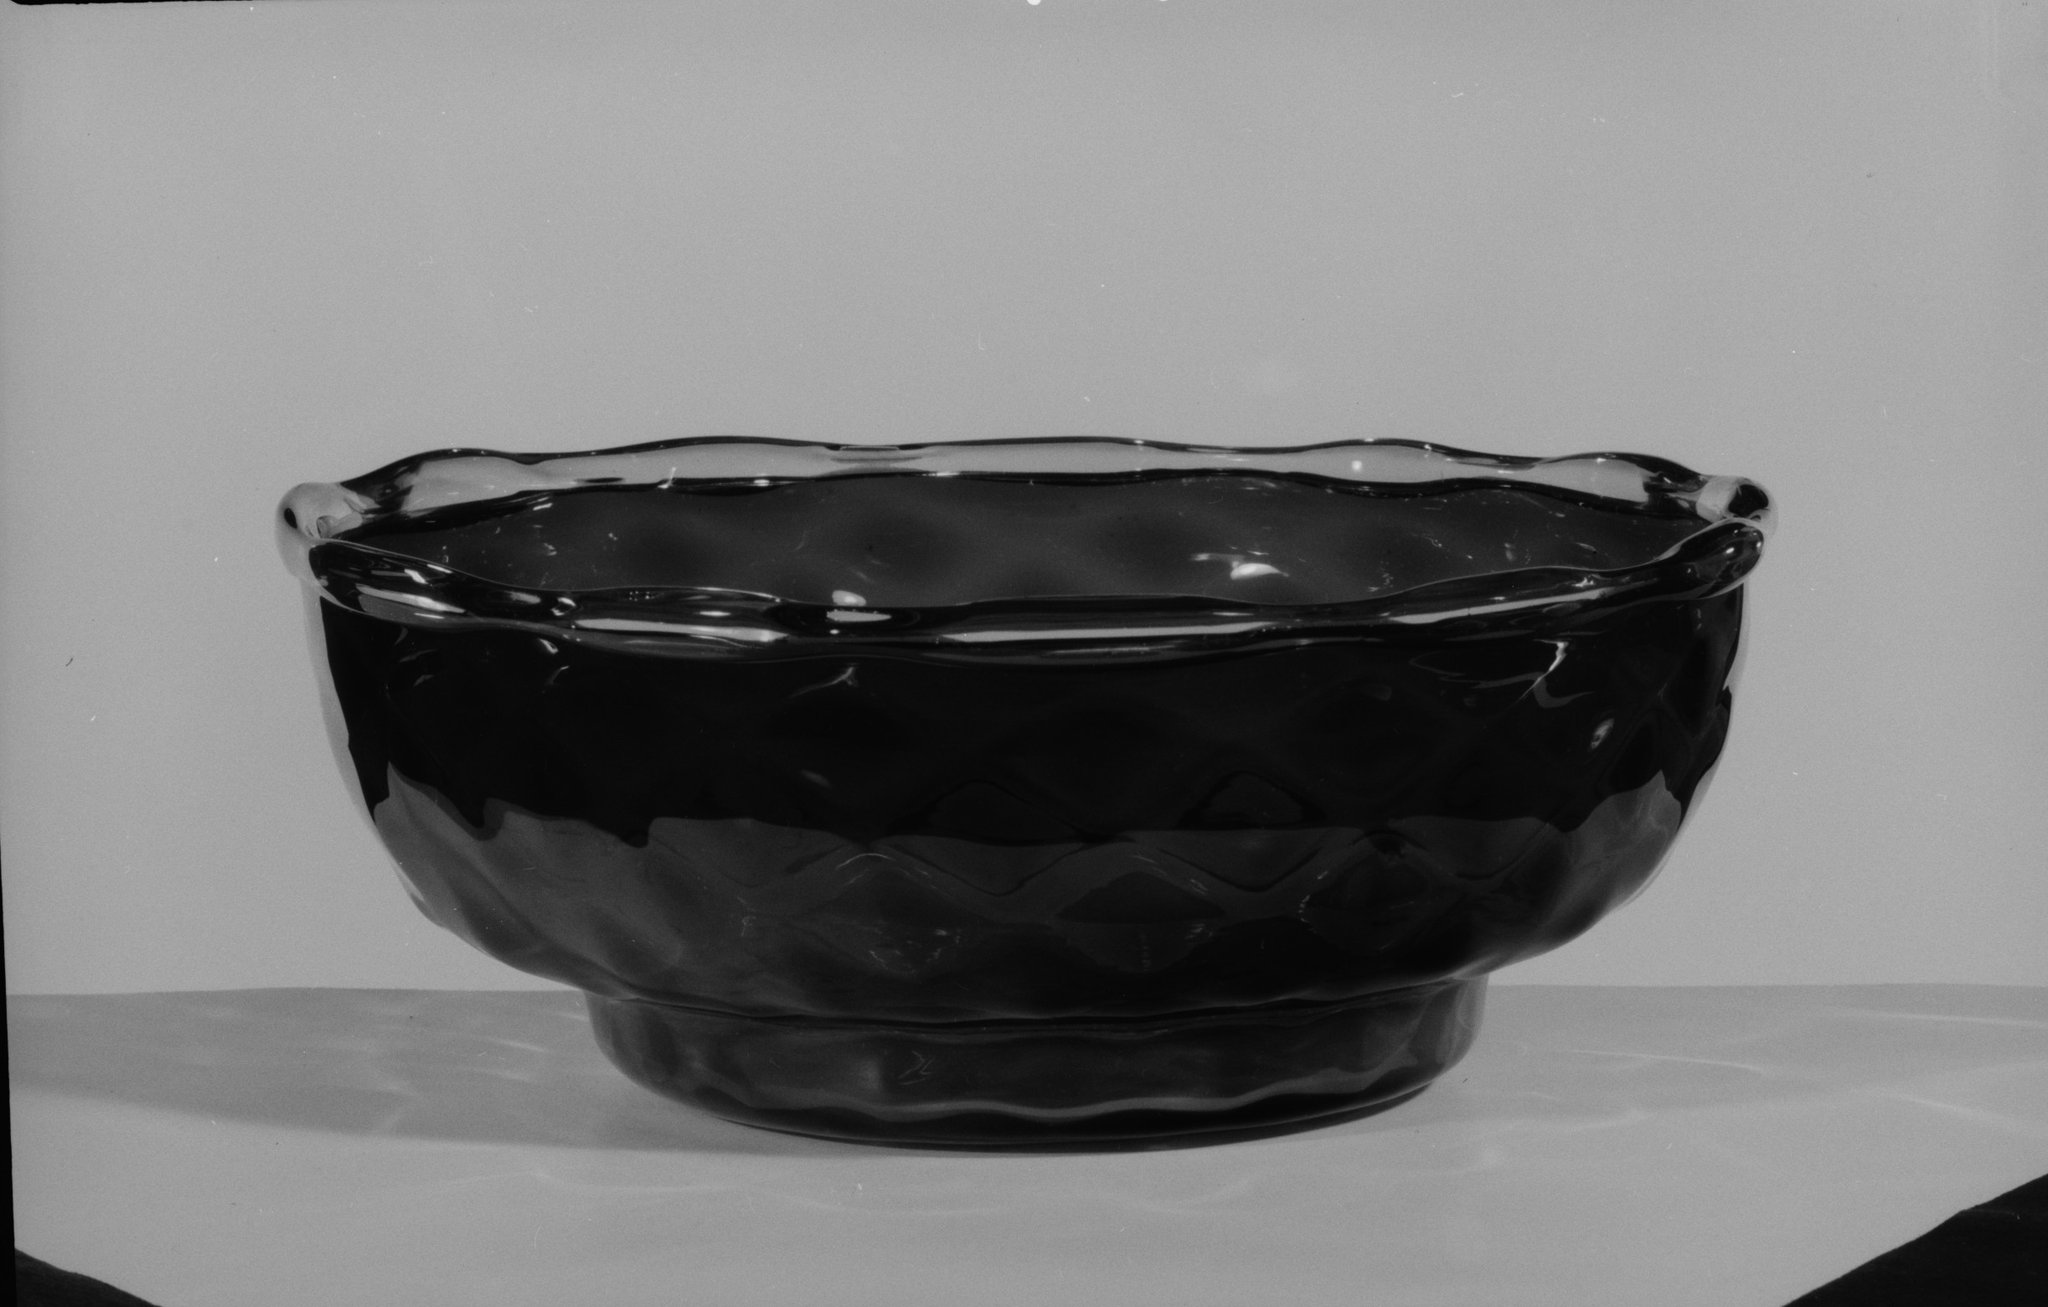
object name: bowl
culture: american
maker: new england glass company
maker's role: maker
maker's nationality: american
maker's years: 1818-1888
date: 1883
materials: glass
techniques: glassblowing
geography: united states